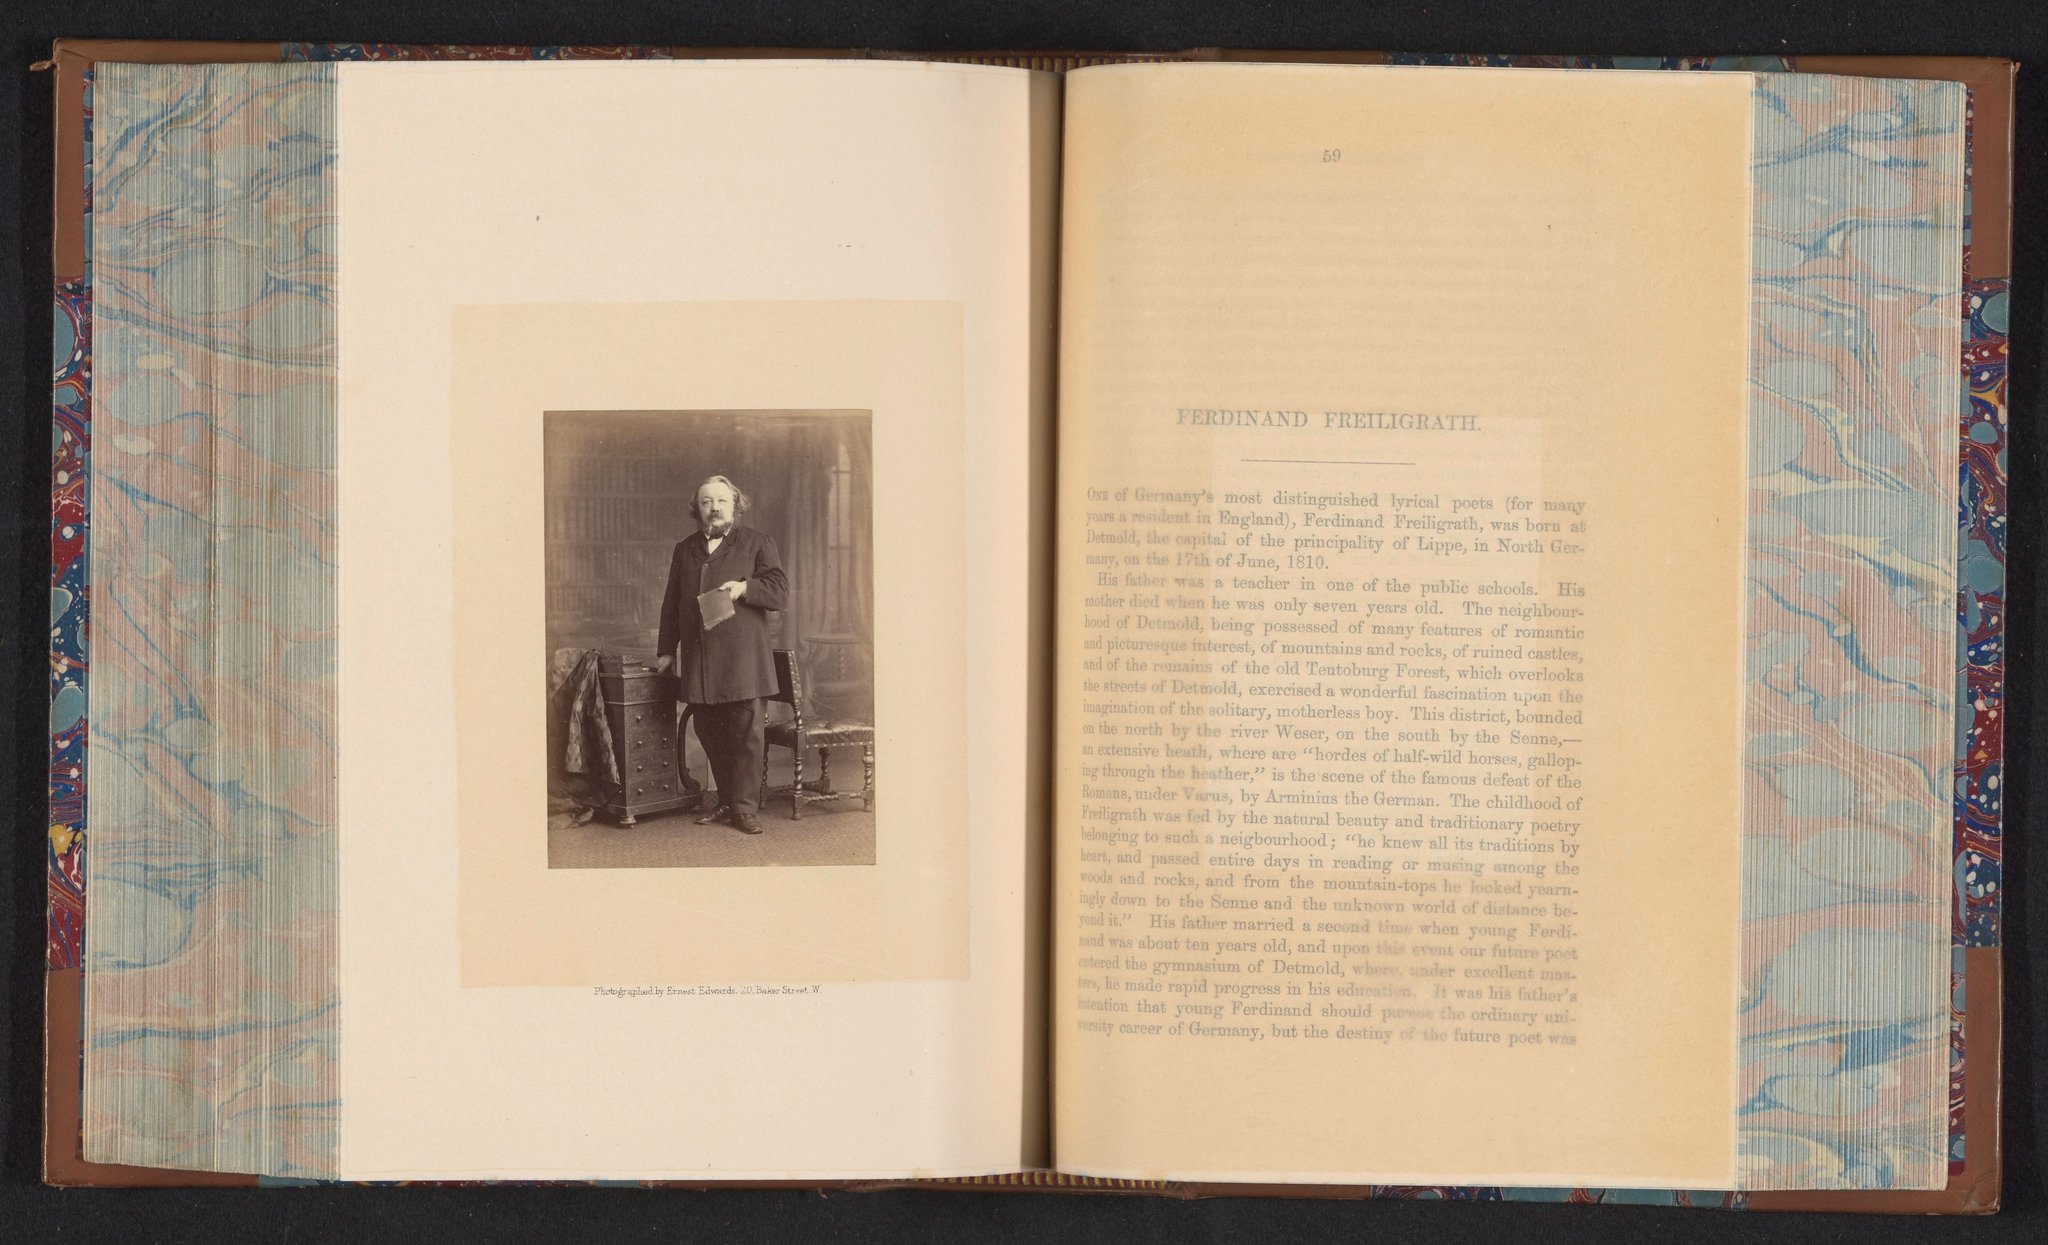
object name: page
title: Portret van Ferdinand Freiligrath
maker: ernest edwards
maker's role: fotograaf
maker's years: 1837-1903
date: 1856-1866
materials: photographic support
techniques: albumen print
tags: ferdinand freiligrath, studio requisites ~ photographer, writer, poet, author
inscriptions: name: ‘Photographed by Ernest Edwards, 20, Baker Street. W.’